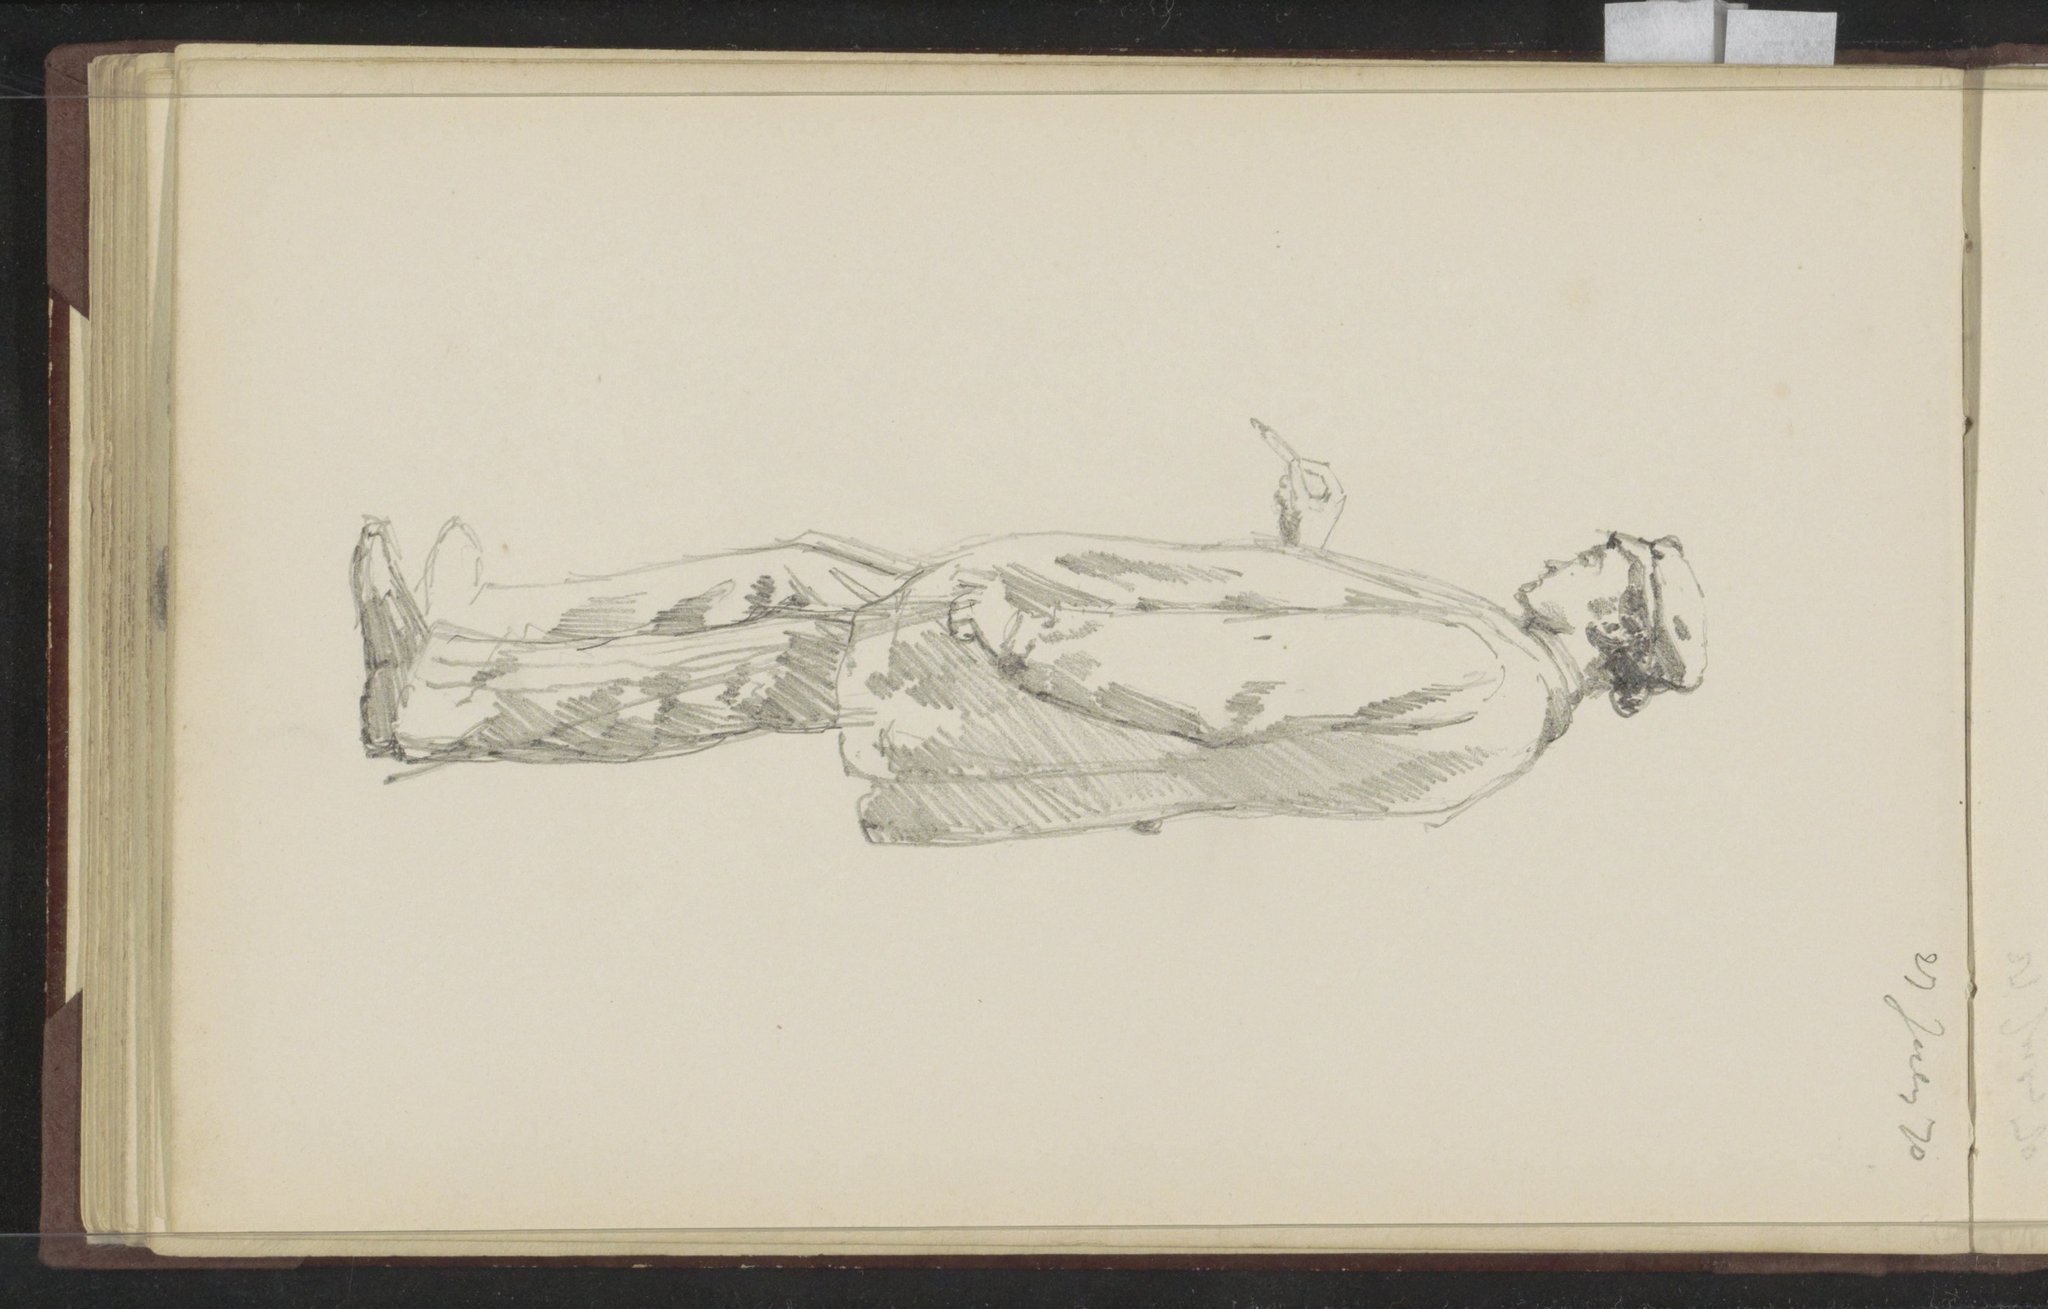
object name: sketchbook leaf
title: Man met een stok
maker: cornelis springer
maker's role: draughtsman, painter, print maker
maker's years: 1817-1891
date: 1870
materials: paper, pencil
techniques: stumping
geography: netherlands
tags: standing figure (+ sideview, profile), writing tools, walking-stick, staff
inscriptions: date: ‘27 July 70’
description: Staande man in profiel met een stok. Hij draagt een pet. In zijn rechterhand heeft hij mogelijk een pen of een potlood. Blad 24 verso uit een schetsboek met 39 bladen, deels vervaardigd te Ulm en Leiden.